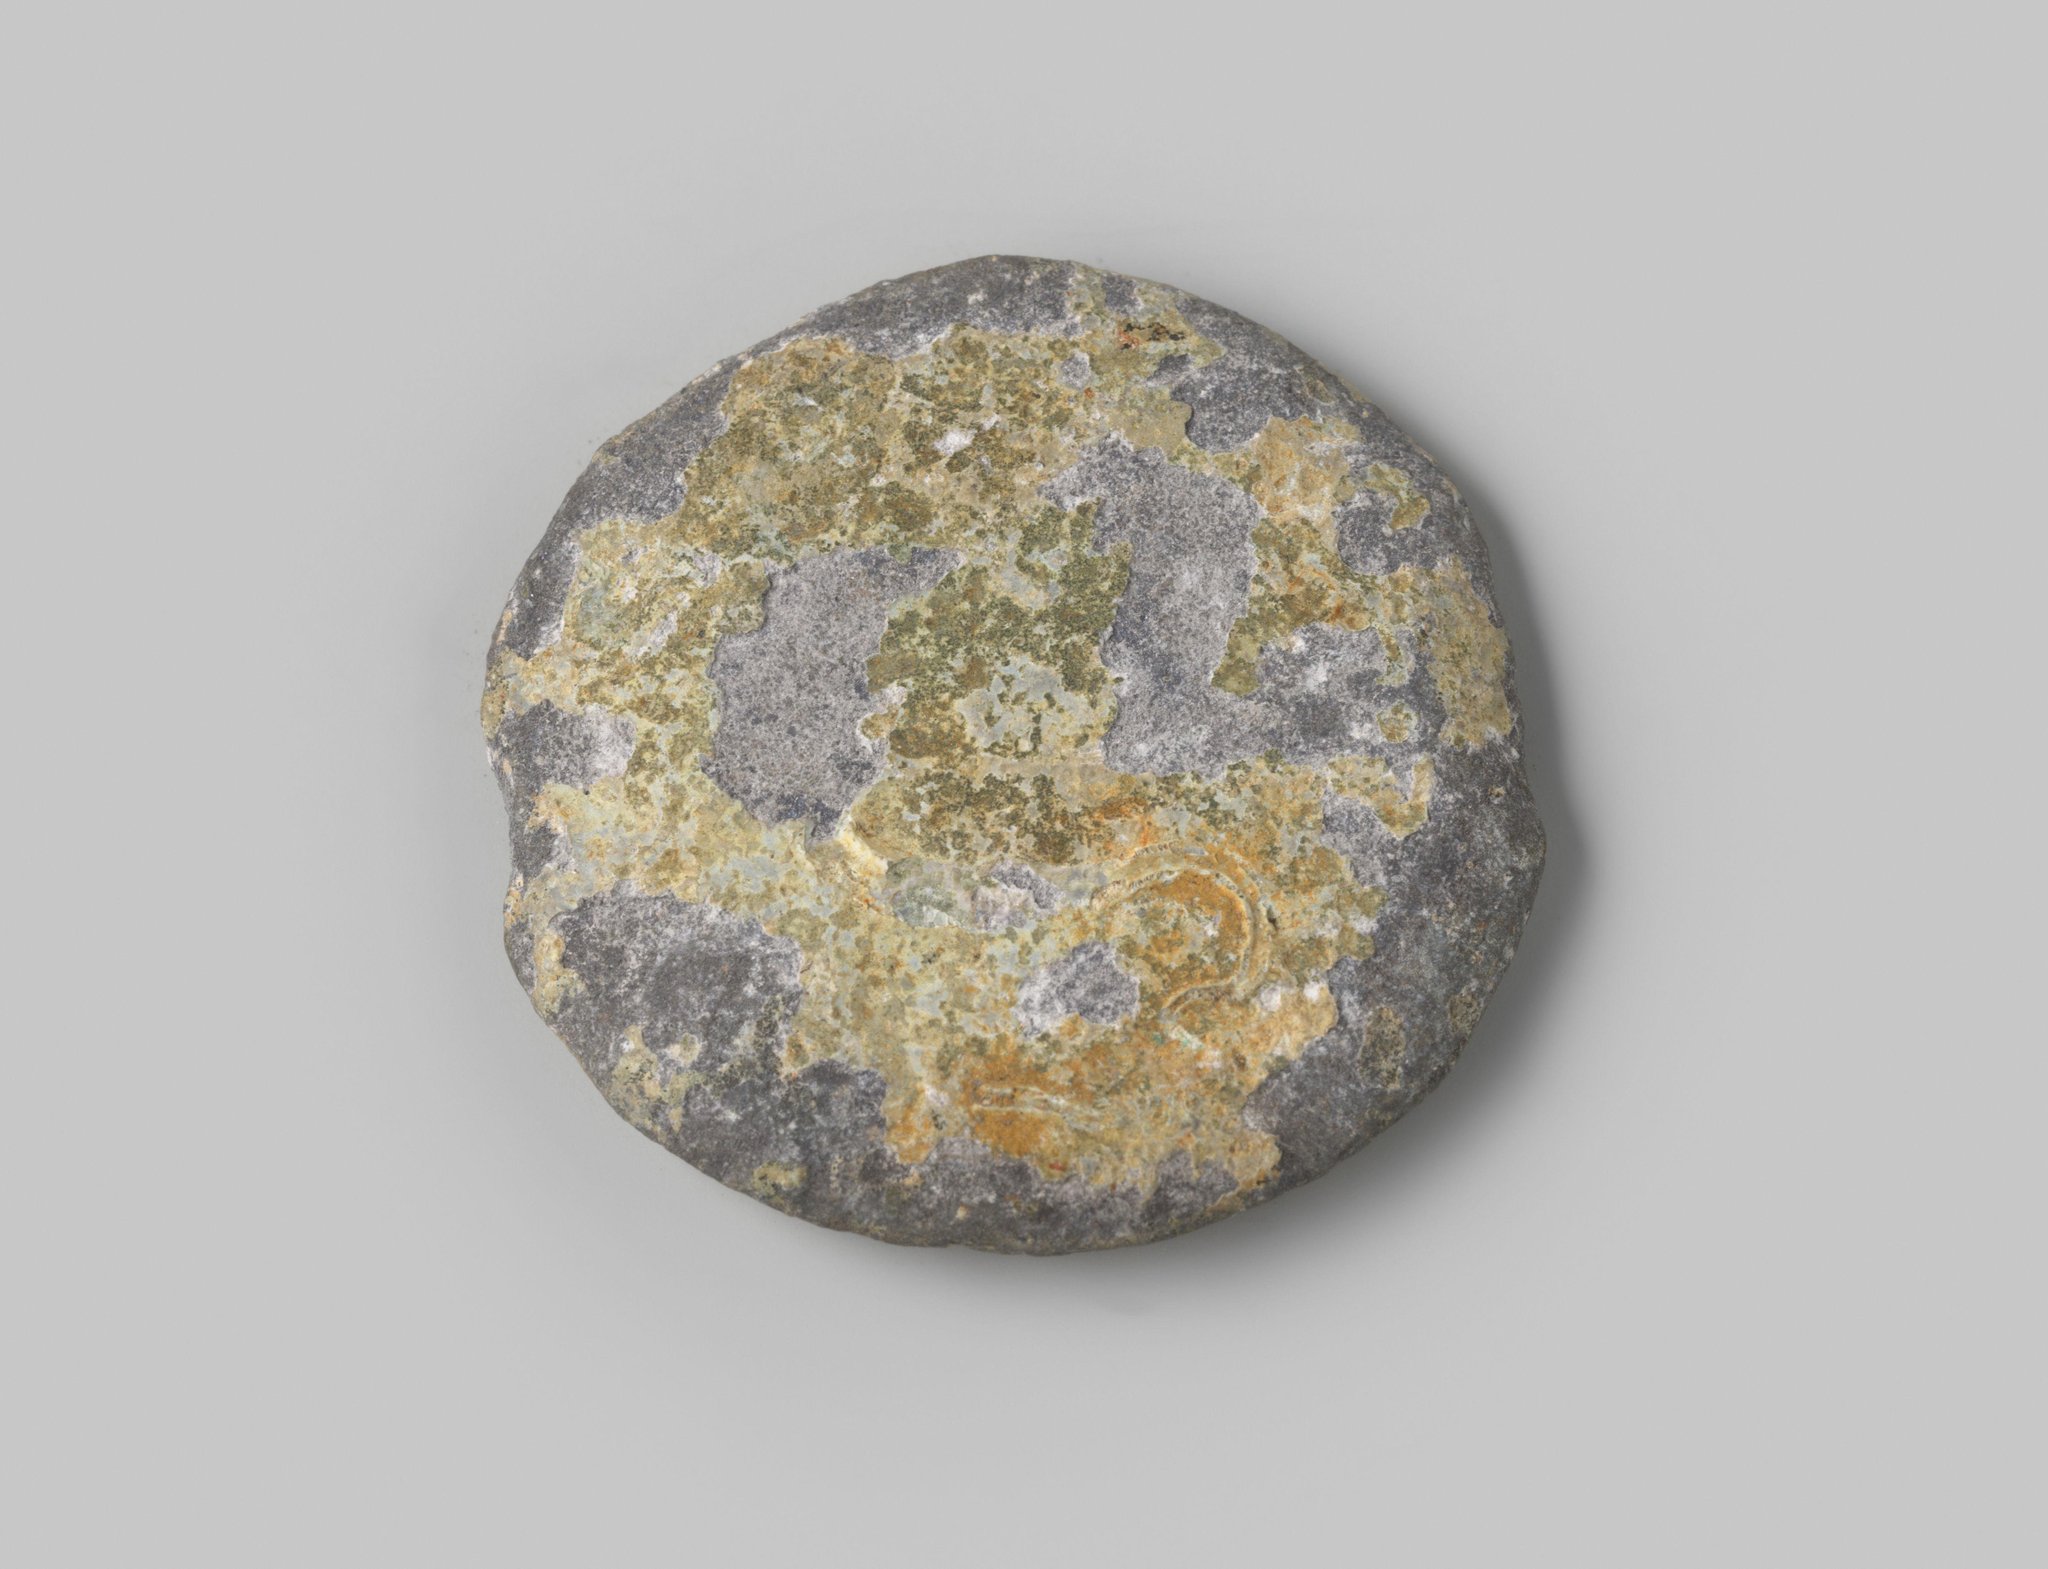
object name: weight scale component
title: Gewicht uit het wrak van de Oost-Indiëvaarder Hollandia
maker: Anonymous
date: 1700-1743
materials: lead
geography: netherlands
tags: verenigde oostindische compagnie, hollandia (schip), annet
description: Disc-shaped weight, circular, lens-shaped in section, corroded.